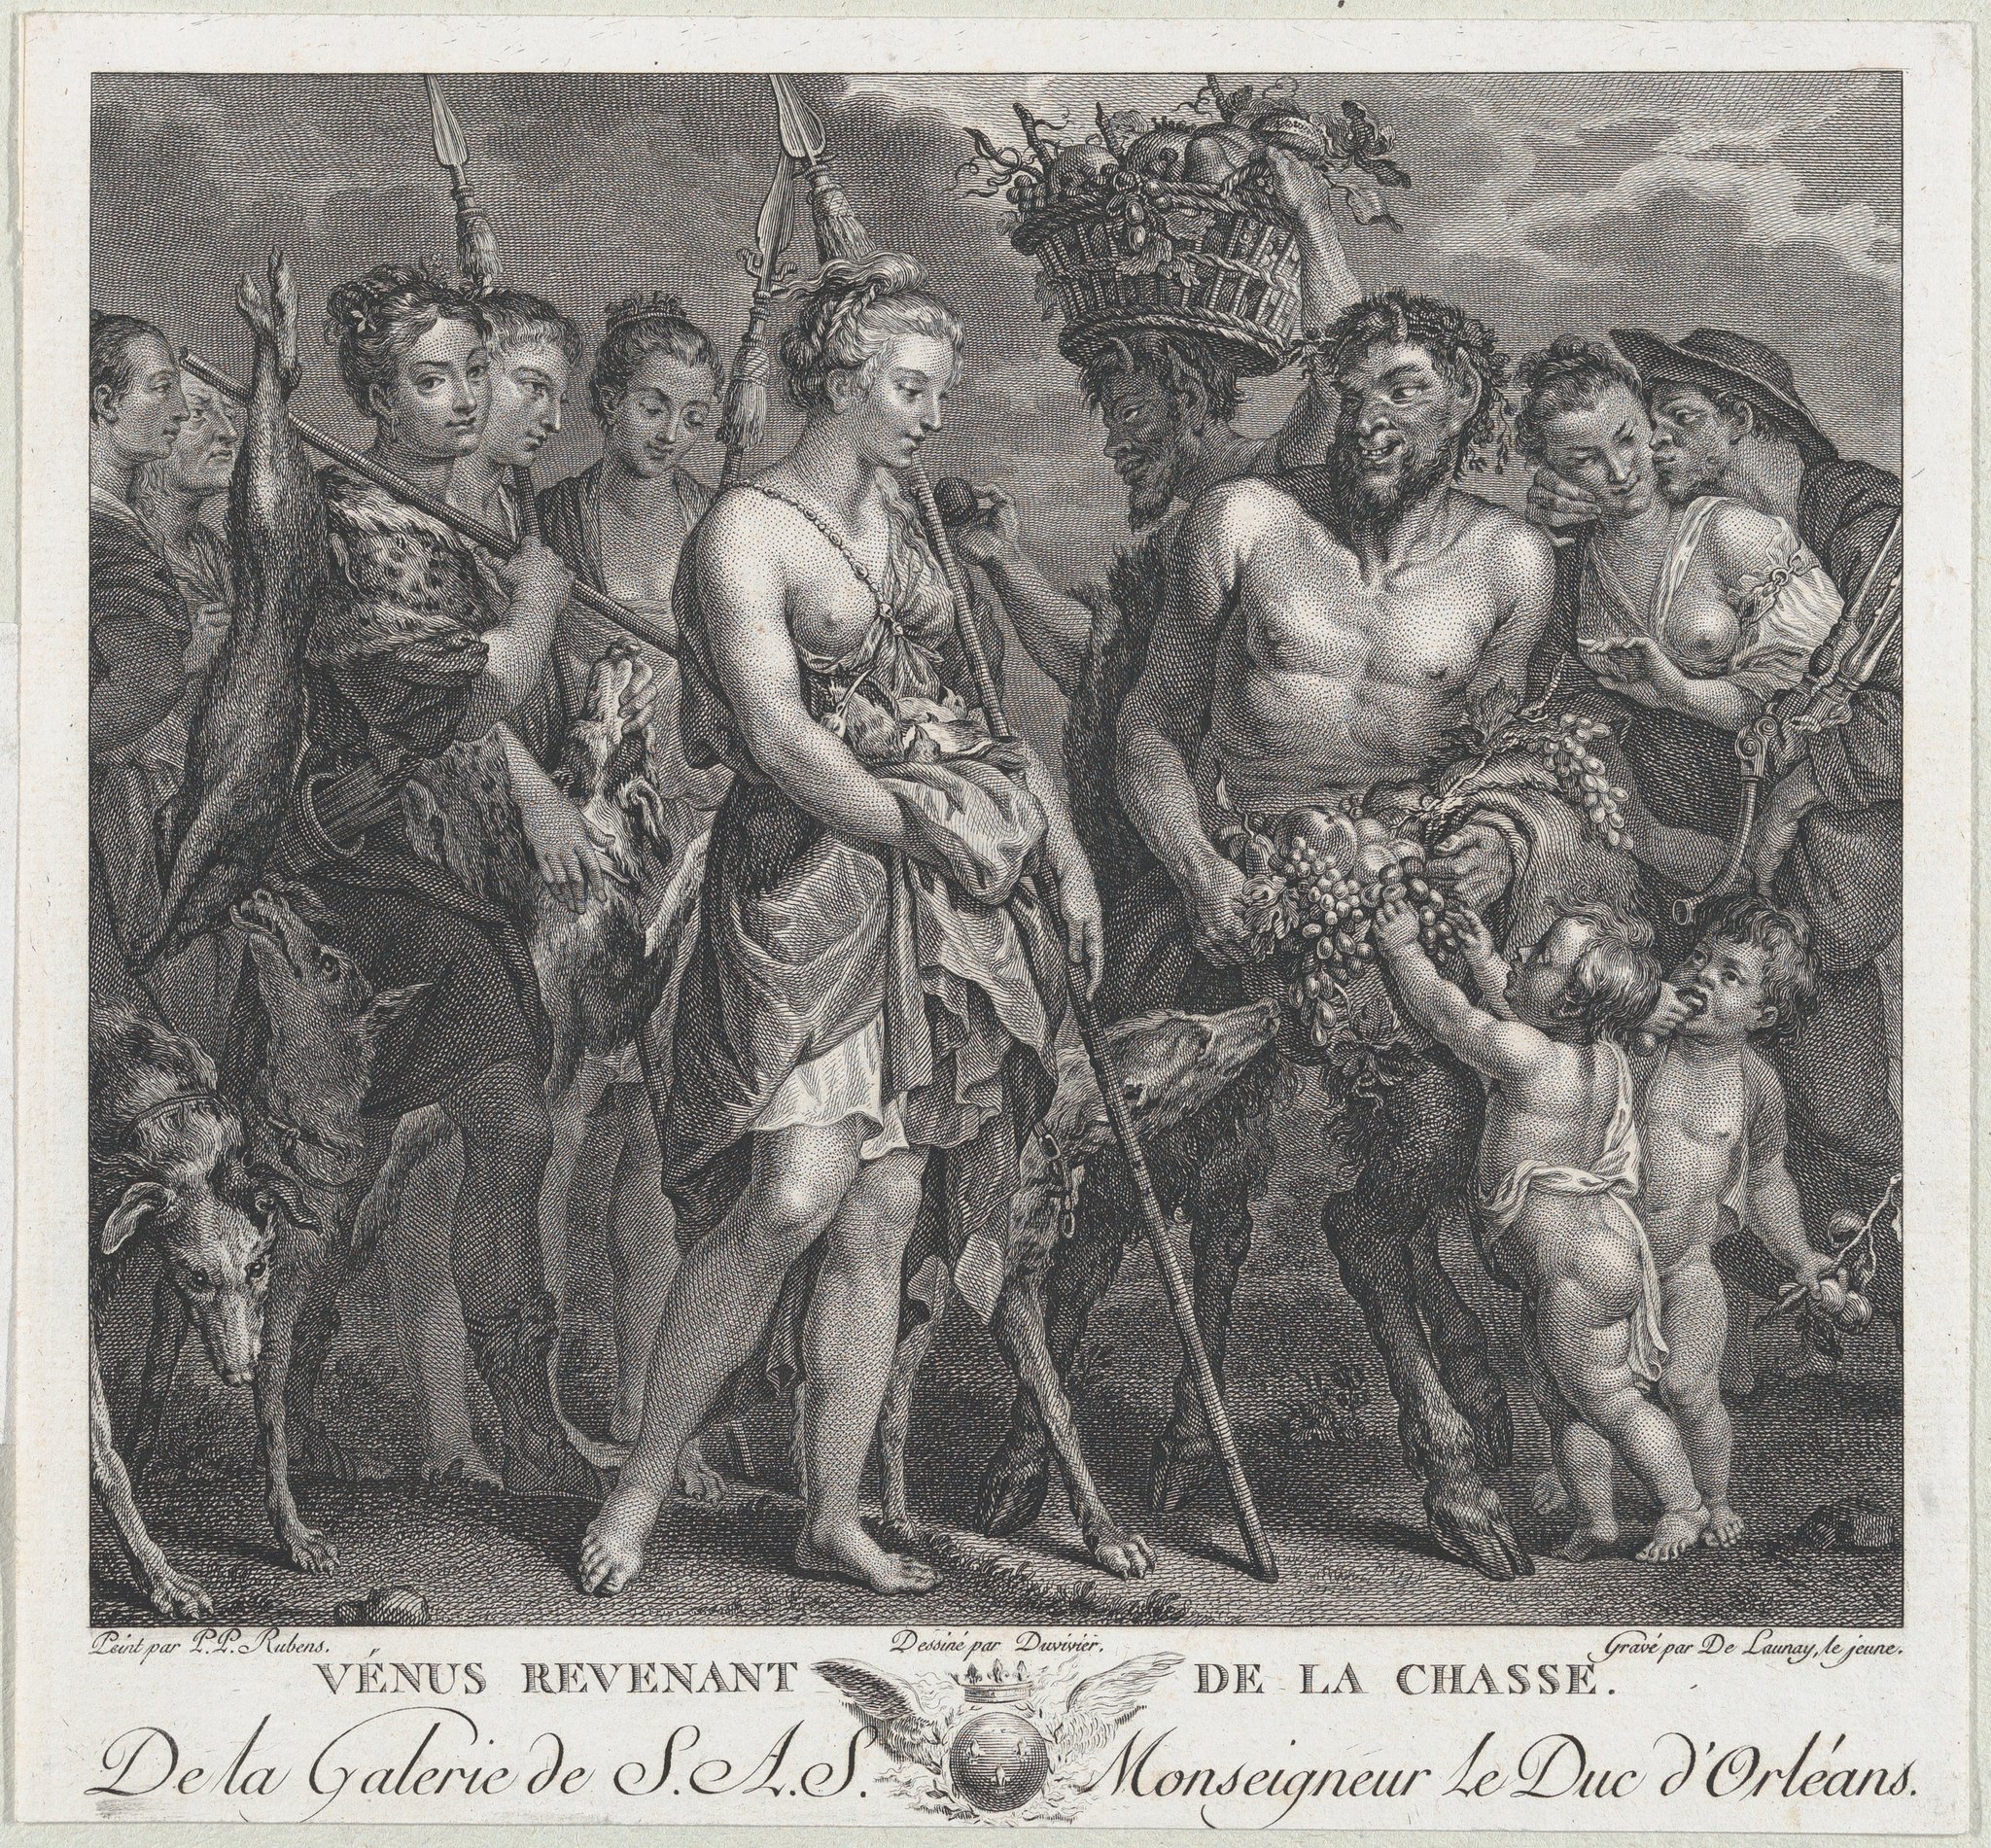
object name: print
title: Diana returning from the chase, accompanied by dogs and her nymphs at left, two satyrs at right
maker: robert de launay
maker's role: artist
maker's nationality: french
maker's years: 1749-1814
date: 1808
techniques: engraving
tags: spears,fruit,nymphs,diana,satyrs,dogs,rabbits,baskets